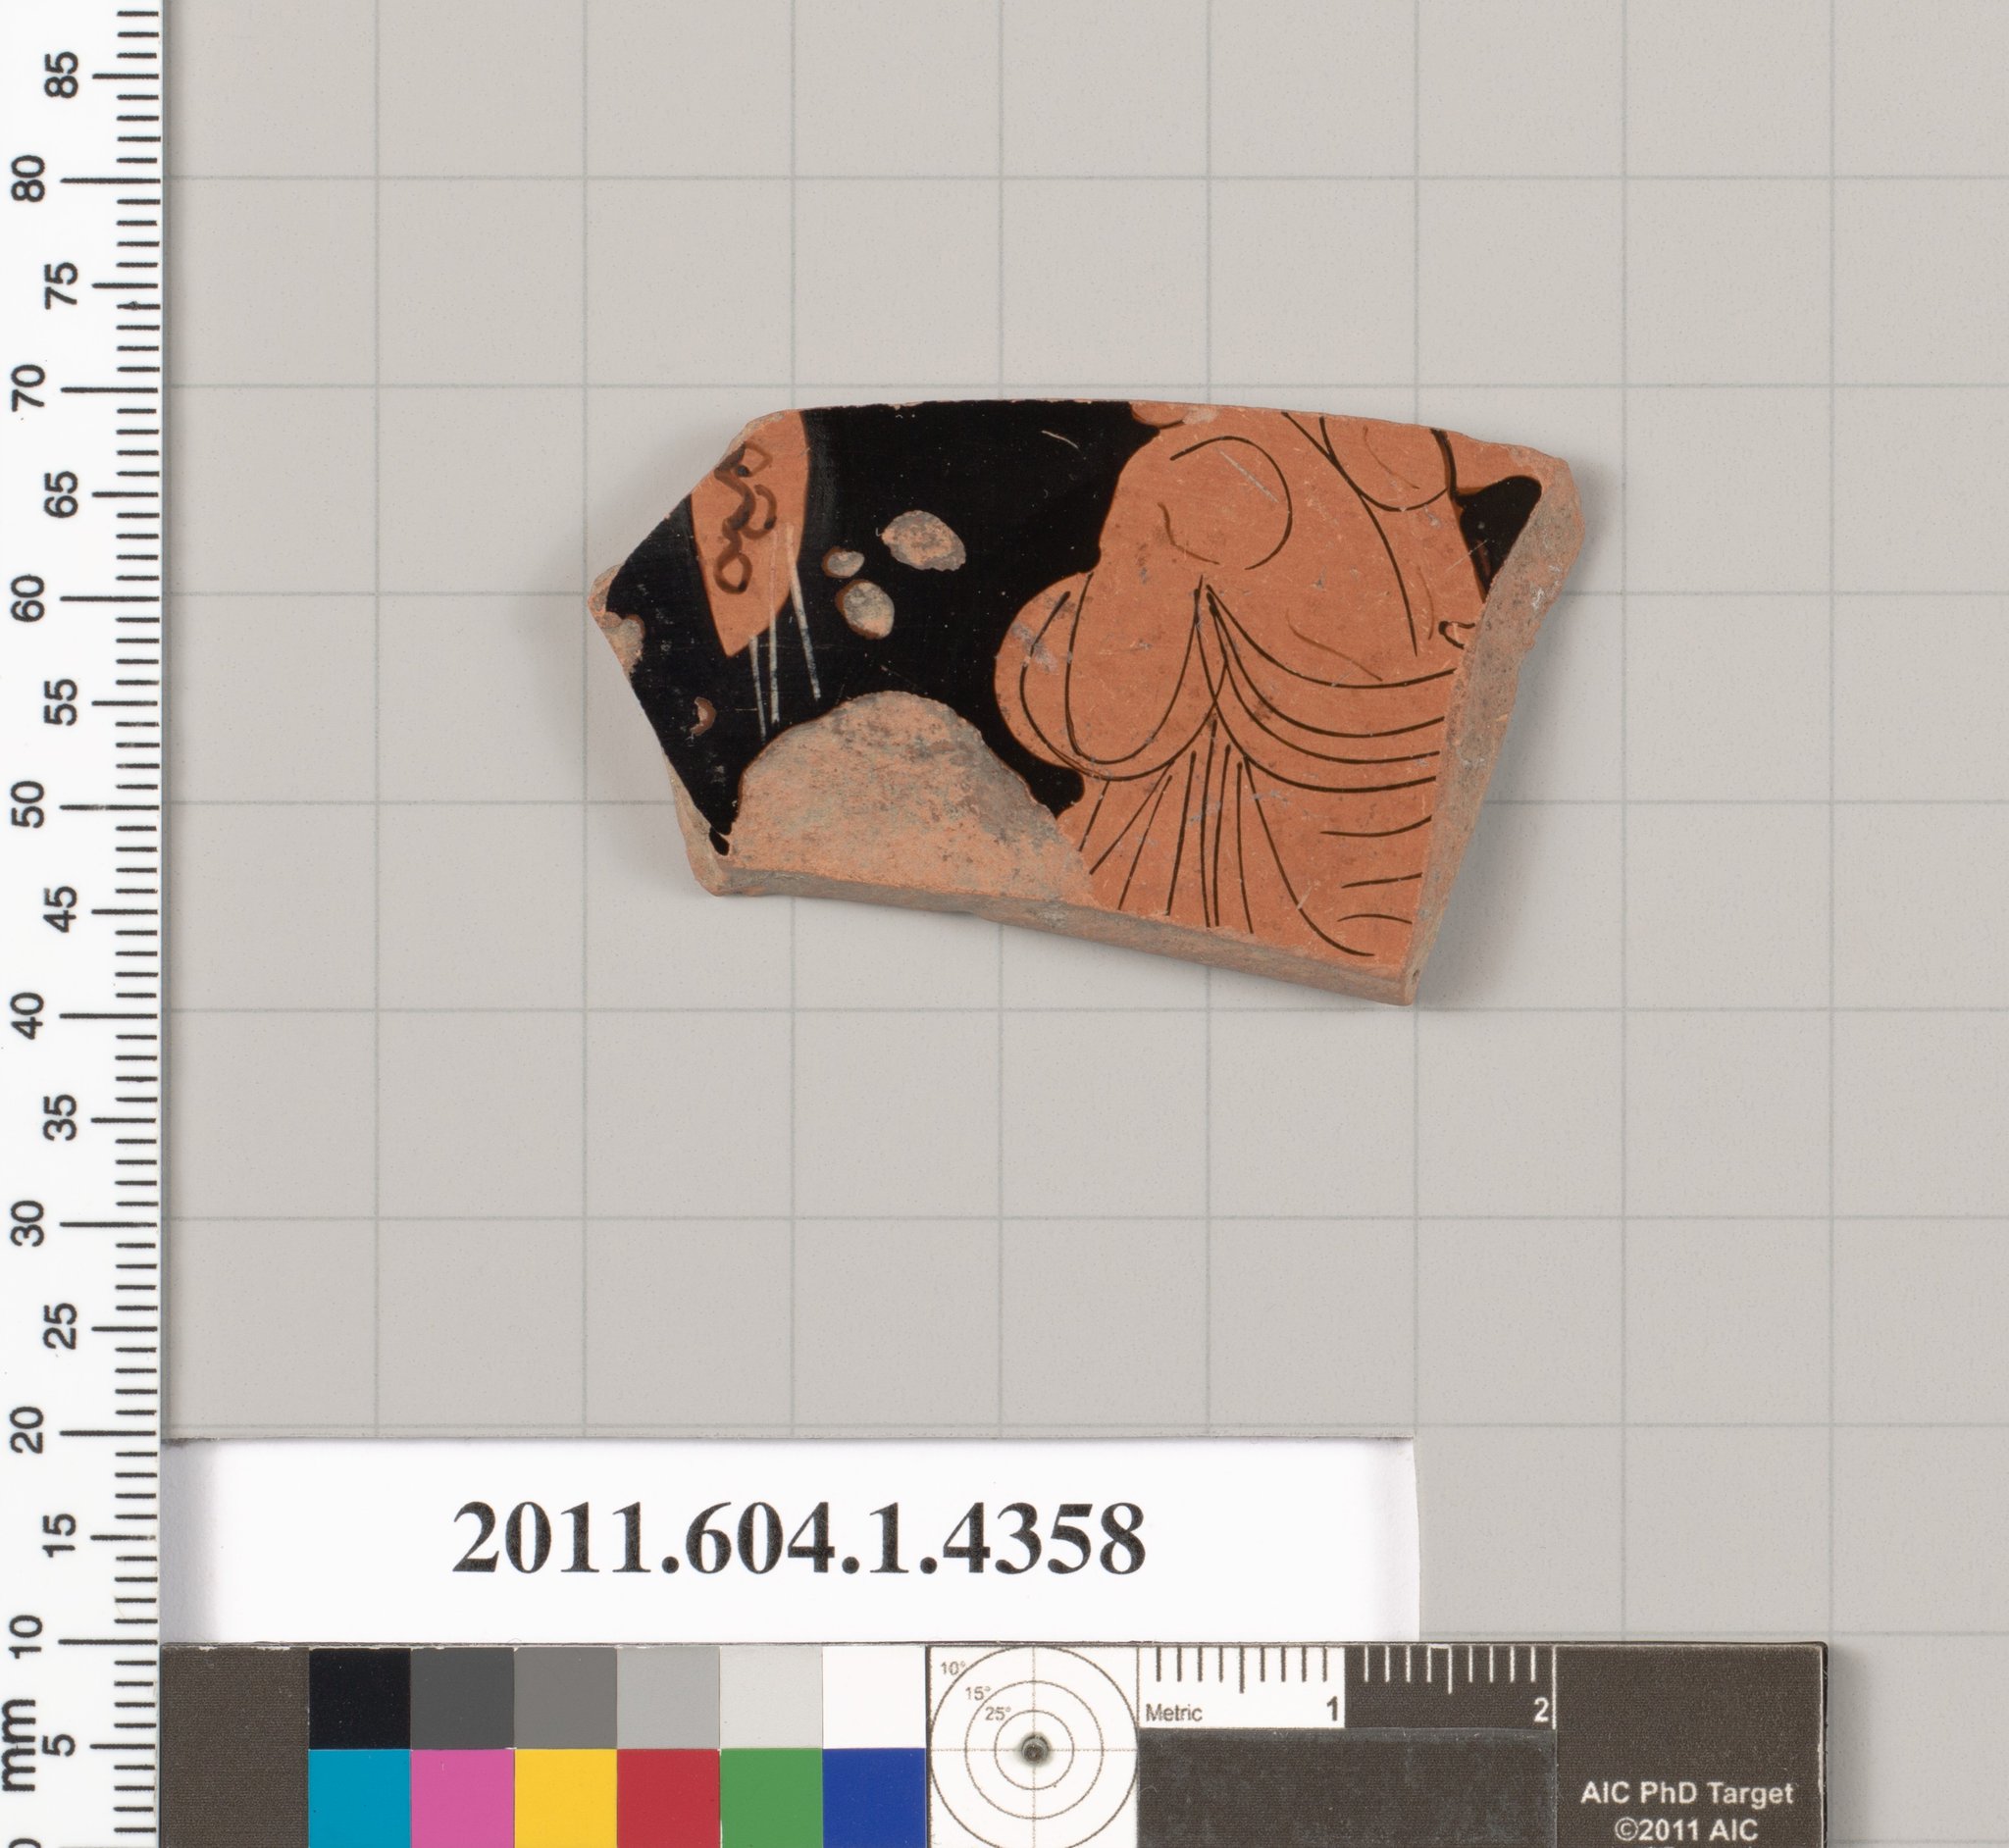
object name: kylix fragment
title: Terracotta fragment of a kylix (drinking cup)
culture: greek, attic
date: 475-451 BCE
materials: terracotta